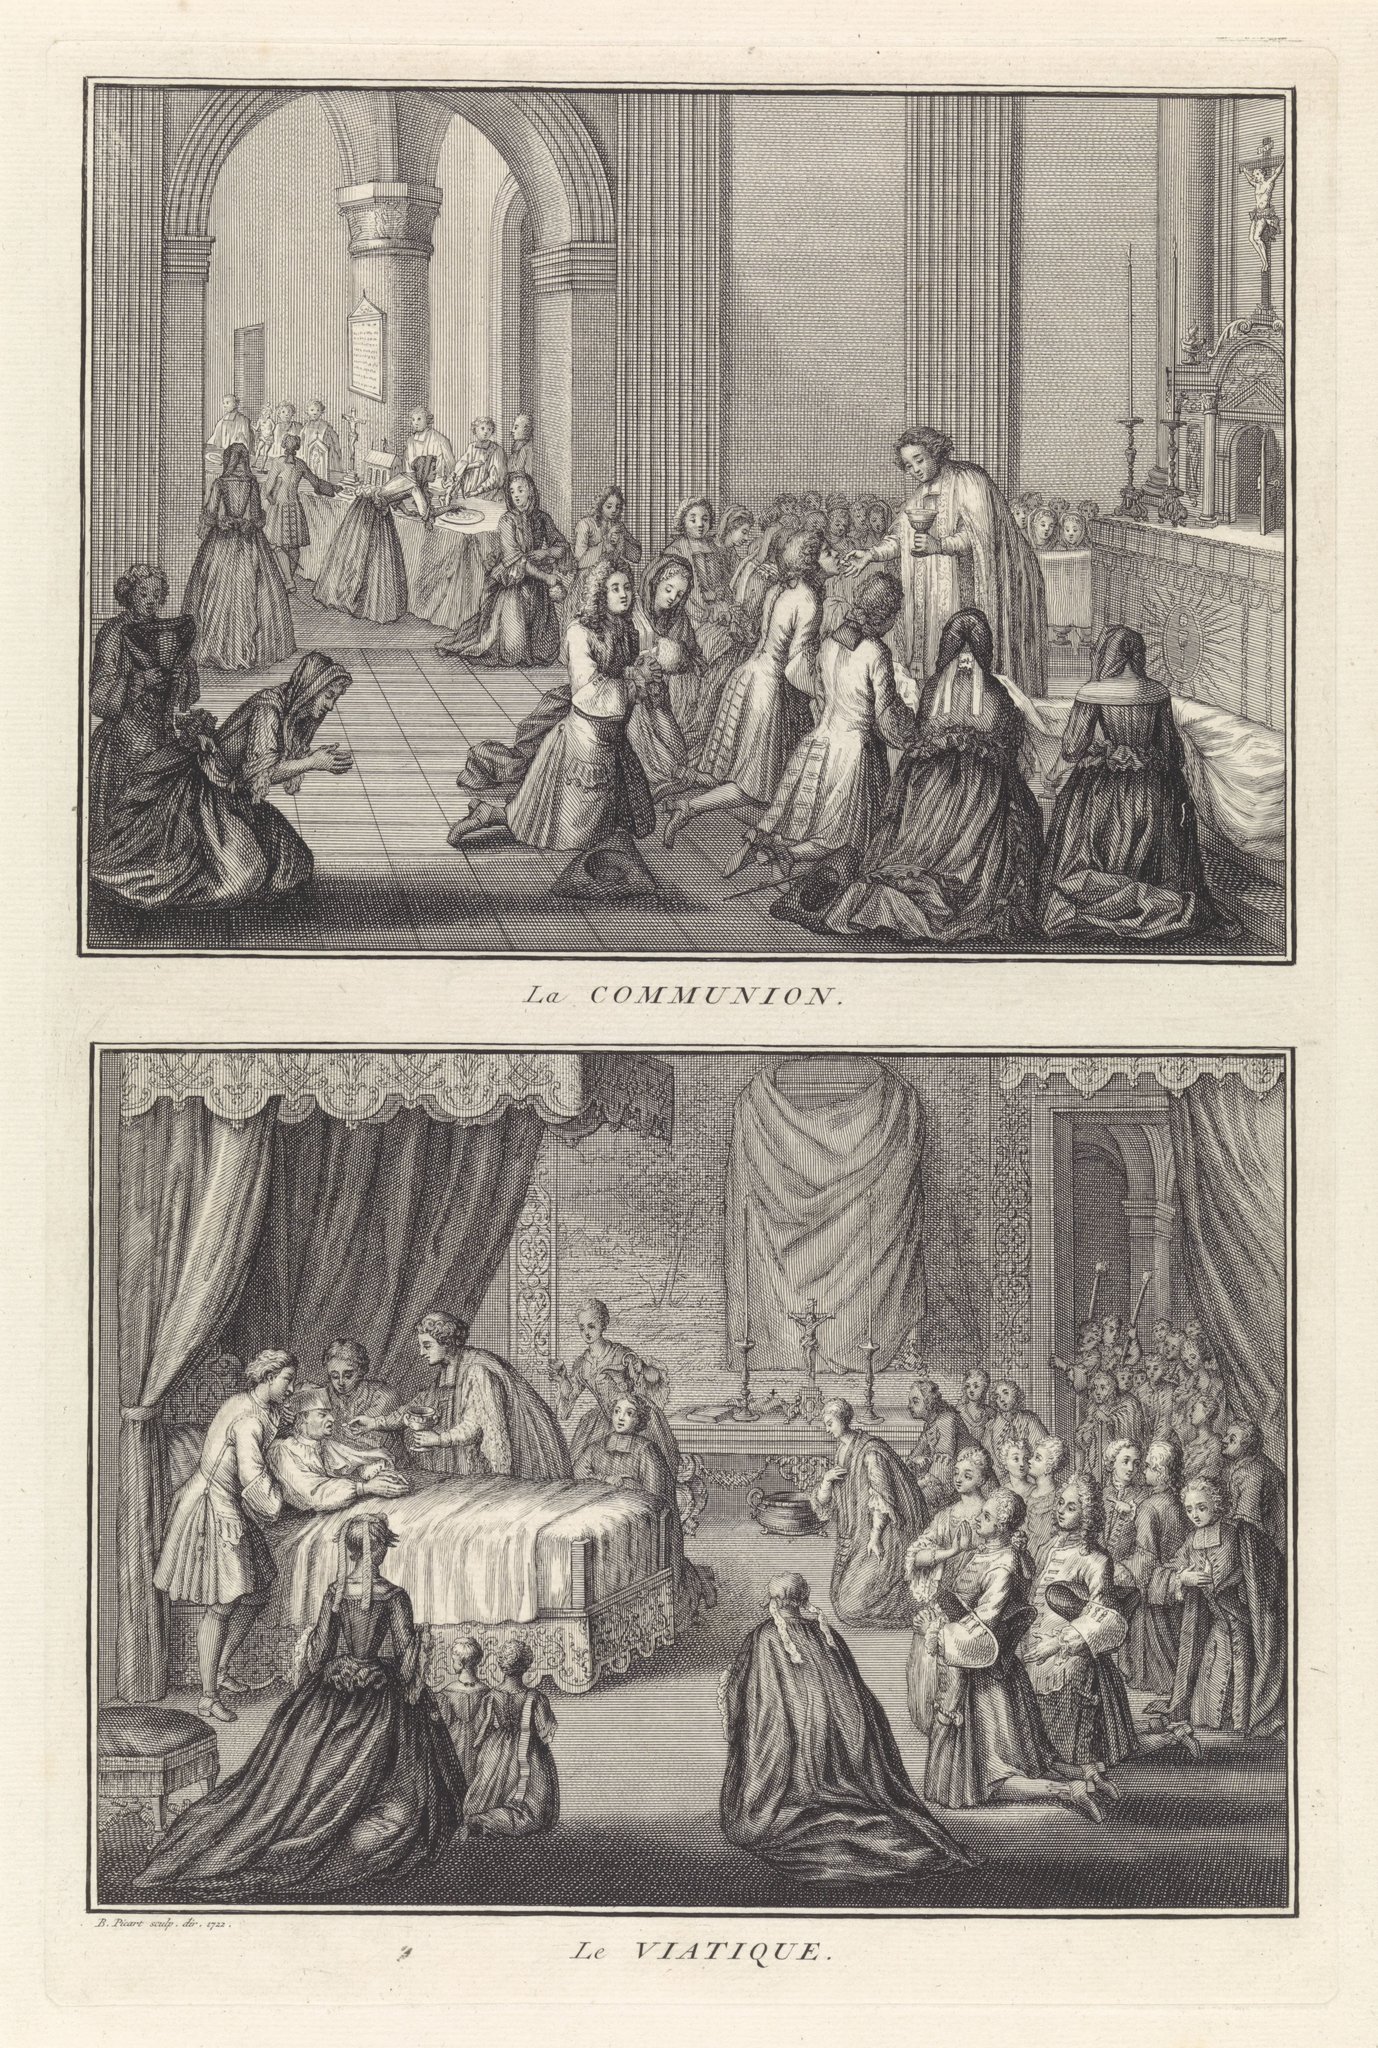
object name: print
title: La Communion / Le Viatique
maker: bernard picart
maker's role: draughtsman, print maker, publisher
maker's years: 1673-1733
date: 1722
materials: paper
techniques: engraving, etching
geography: amsterdam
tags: the eucharist ~ the fourth of the seven sacraments, last communion, administering of the holy viaticum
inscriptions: collector's mark: Lugt 2228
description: Blad met twee voorstellingen van het rooms-katholieke sacrament van de eucharistie. Boven: Mannen en vrouwen knielen om de Heilige Communie te ontvangen. Een priester geeft een man de hostie. Onder: Aan een stervende man wordt door een priester de laatste communie of het Viaticum toegediend. Rond het bed knielen de familieleden en huisgenoten van de stervende.